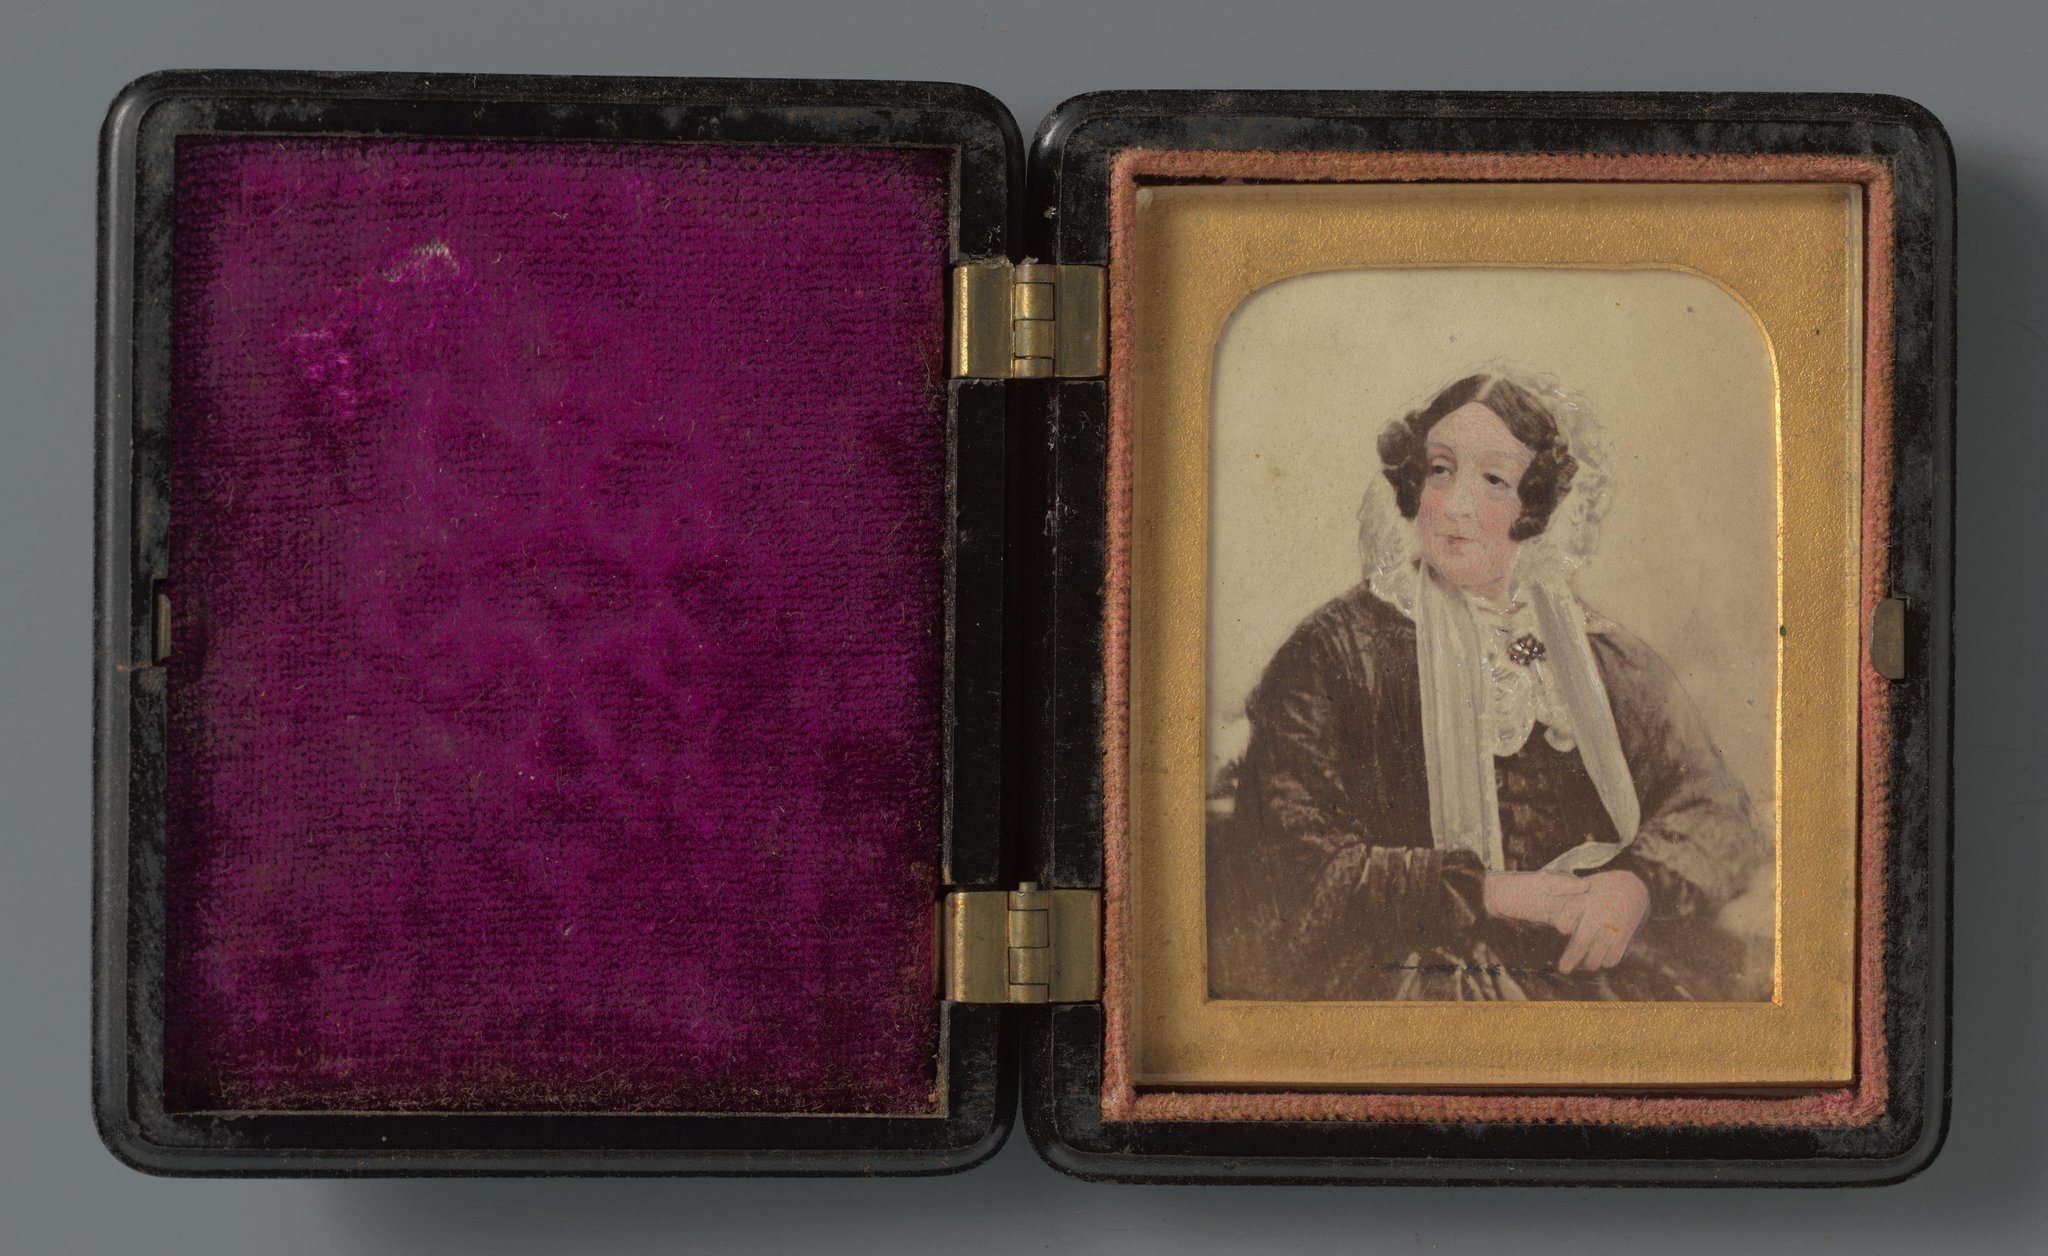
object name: photograph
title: Portret van een onbekende vrouw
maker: Anonymous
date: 1855-1870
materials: glass, metal, photographic support, plastic, textile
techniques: albumen print, hand coloring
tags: historical persons - bb - woman, head-gear: hat